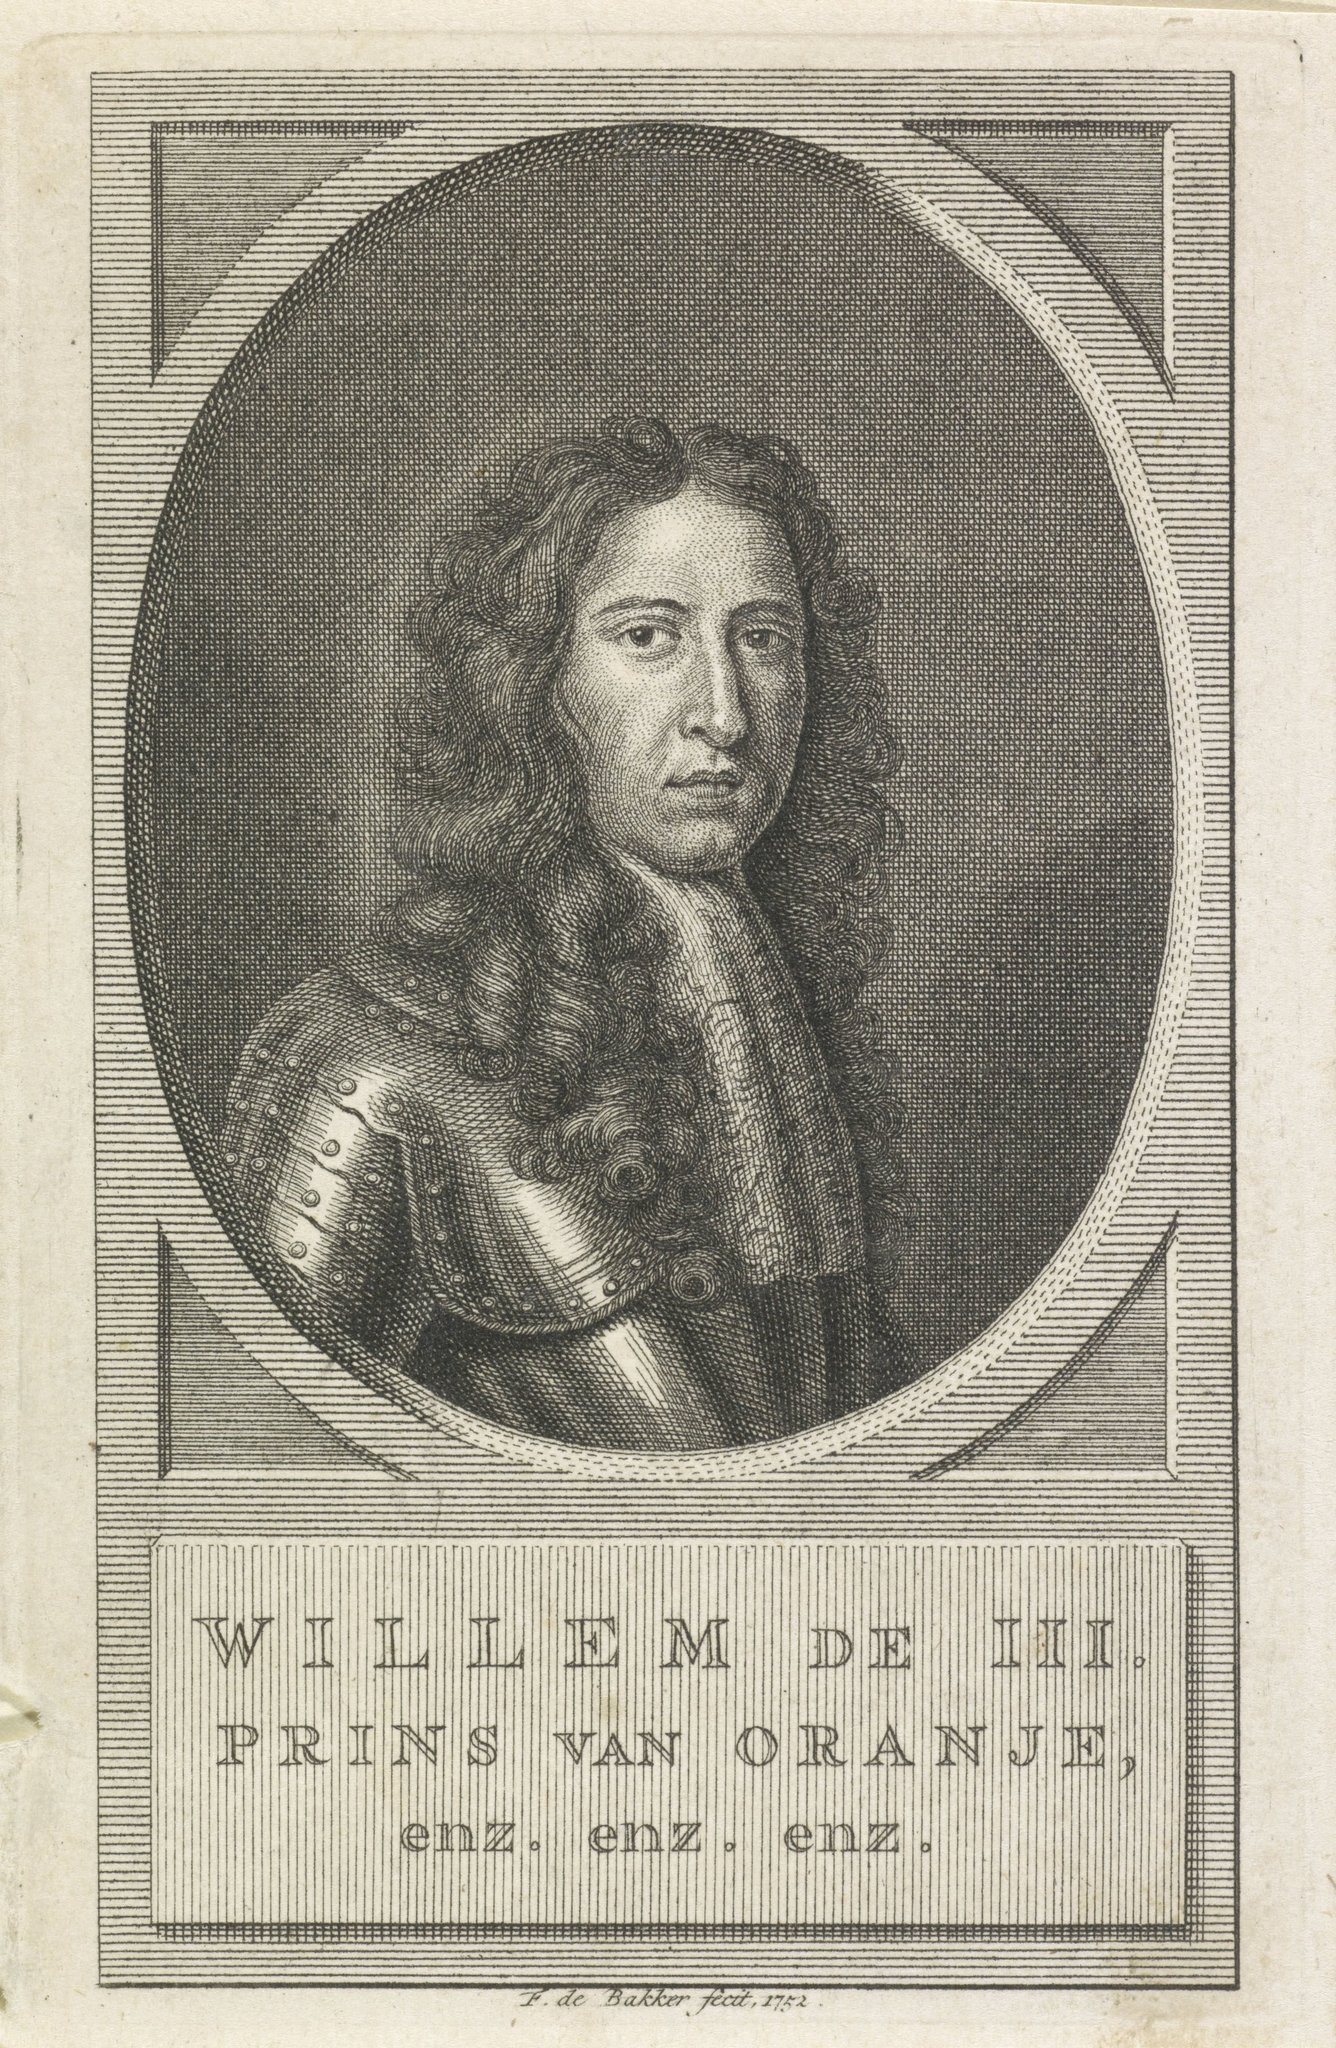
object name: print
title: Portret van Willem III, prins van Oranje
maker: frans de bakker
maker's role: print maker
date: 1752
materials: paper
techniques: engraving, etching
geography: amsterdam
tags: the hague, william iii (prince of orange and king of england, scotland, and ireland)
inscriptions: date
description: De hier vermelde titel verwijst naar de hoogst verkregen titel van de geportretteerde, niet per se naar de titel die de geportretteerde op deze voorstelling draagt.